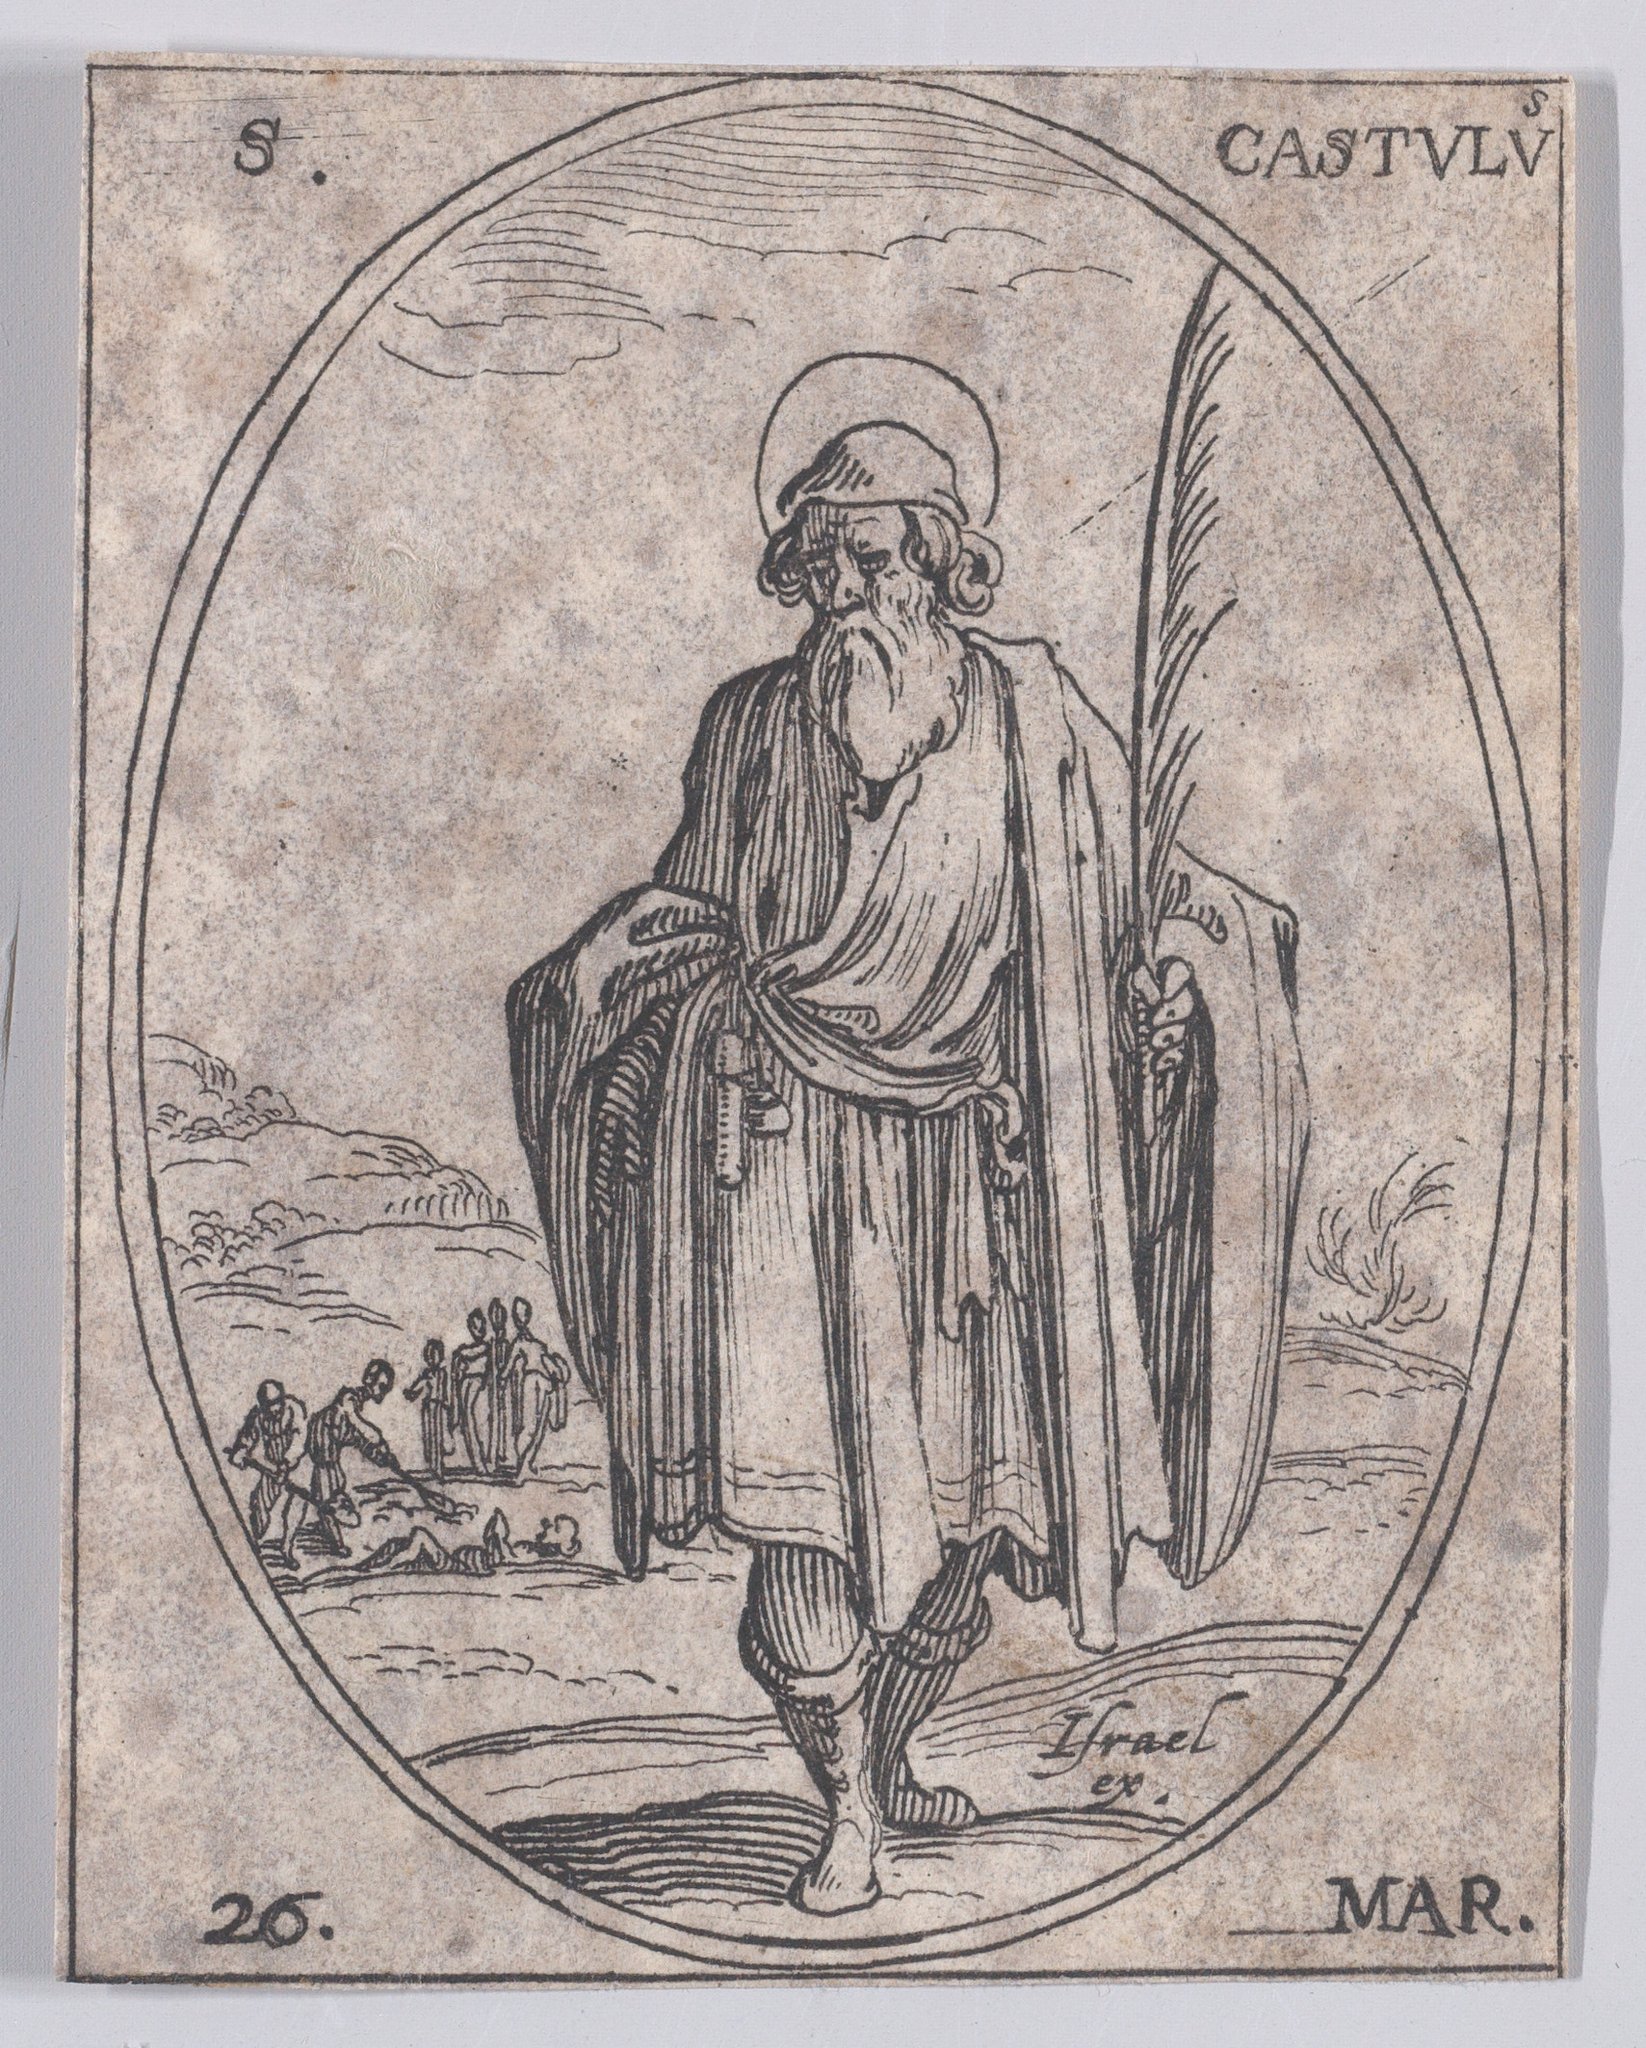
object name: print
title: S. Castule (St. Castulus), March 26th, from "Les Images De Tous Les Saincts et Saintes de L'Année" (Images of All of the Saints and Religious Events of the Year)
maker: jacques callot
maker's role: artist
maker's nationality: french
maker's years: 1592-1635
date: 1636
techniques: etching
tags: men,saints